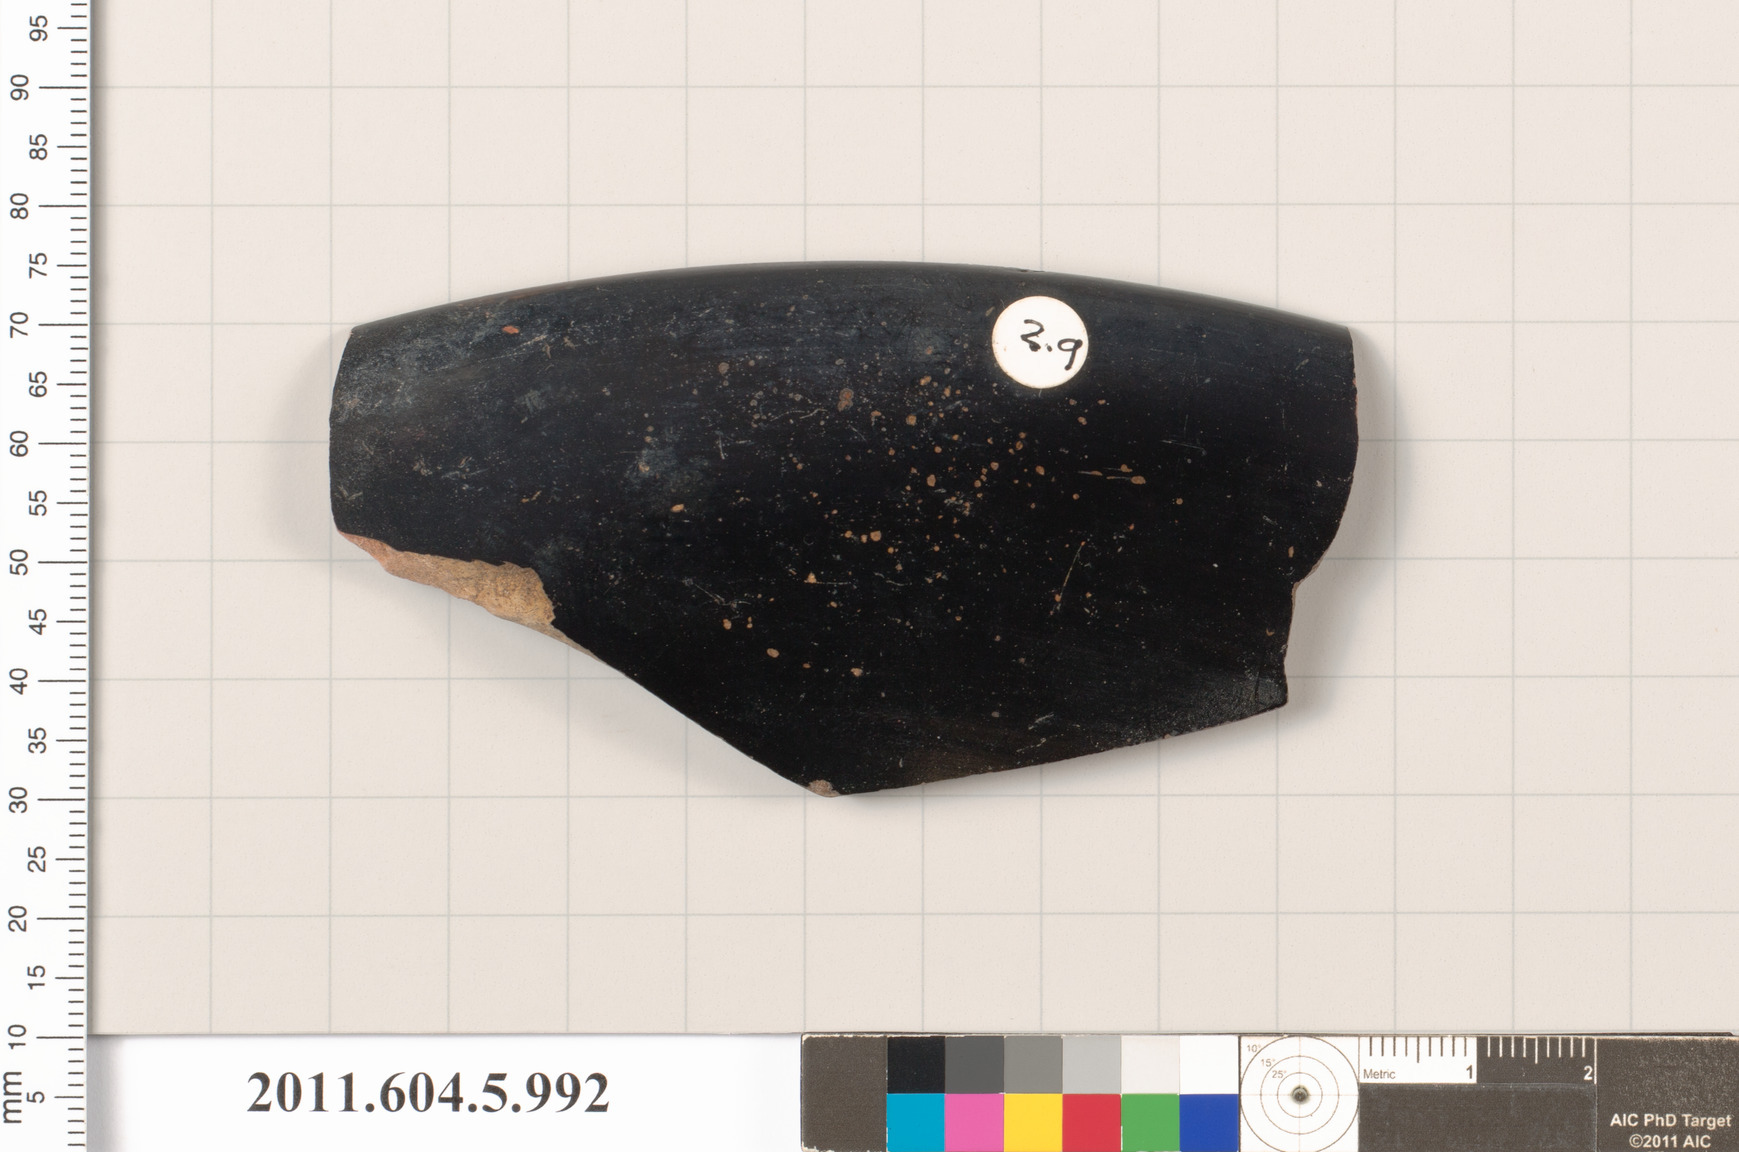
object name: kylix fragment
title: Terracotta rim fragment of a kylix (drinking cup)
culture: greek, attic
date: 600-401 BCE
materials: terracotta